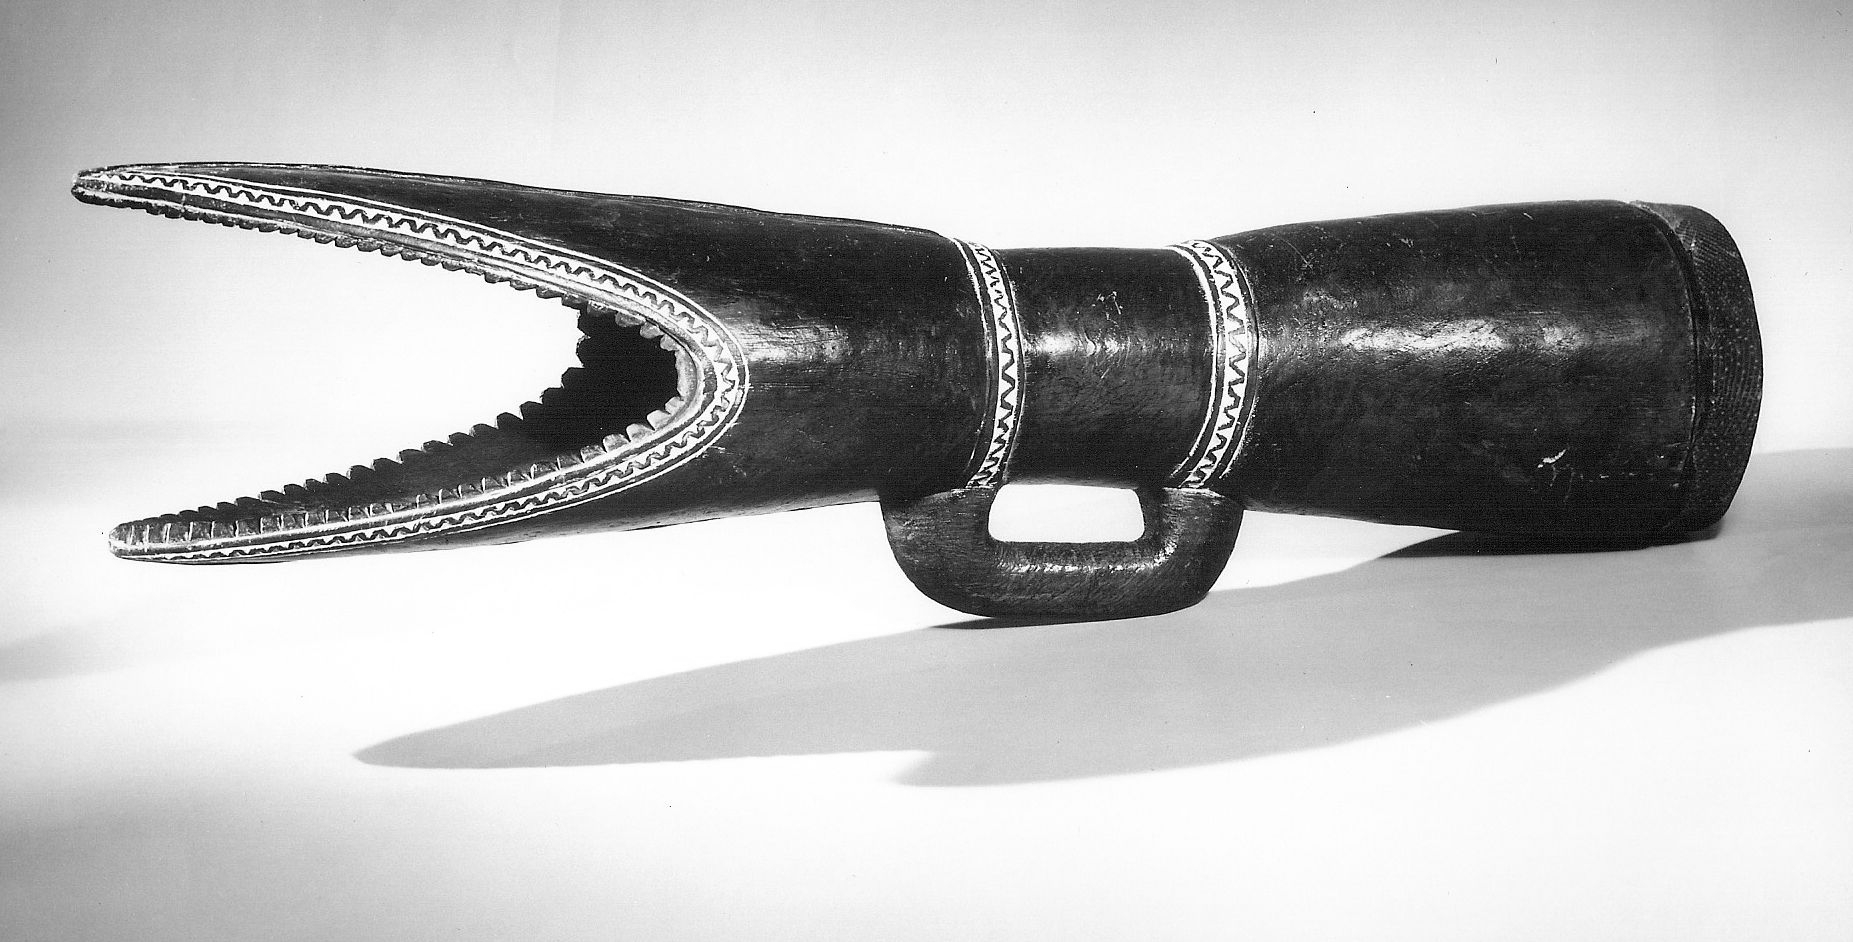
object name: apa drum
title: Apa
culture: melanesian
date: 1867-1900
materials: skin, wood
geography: papua new guinea